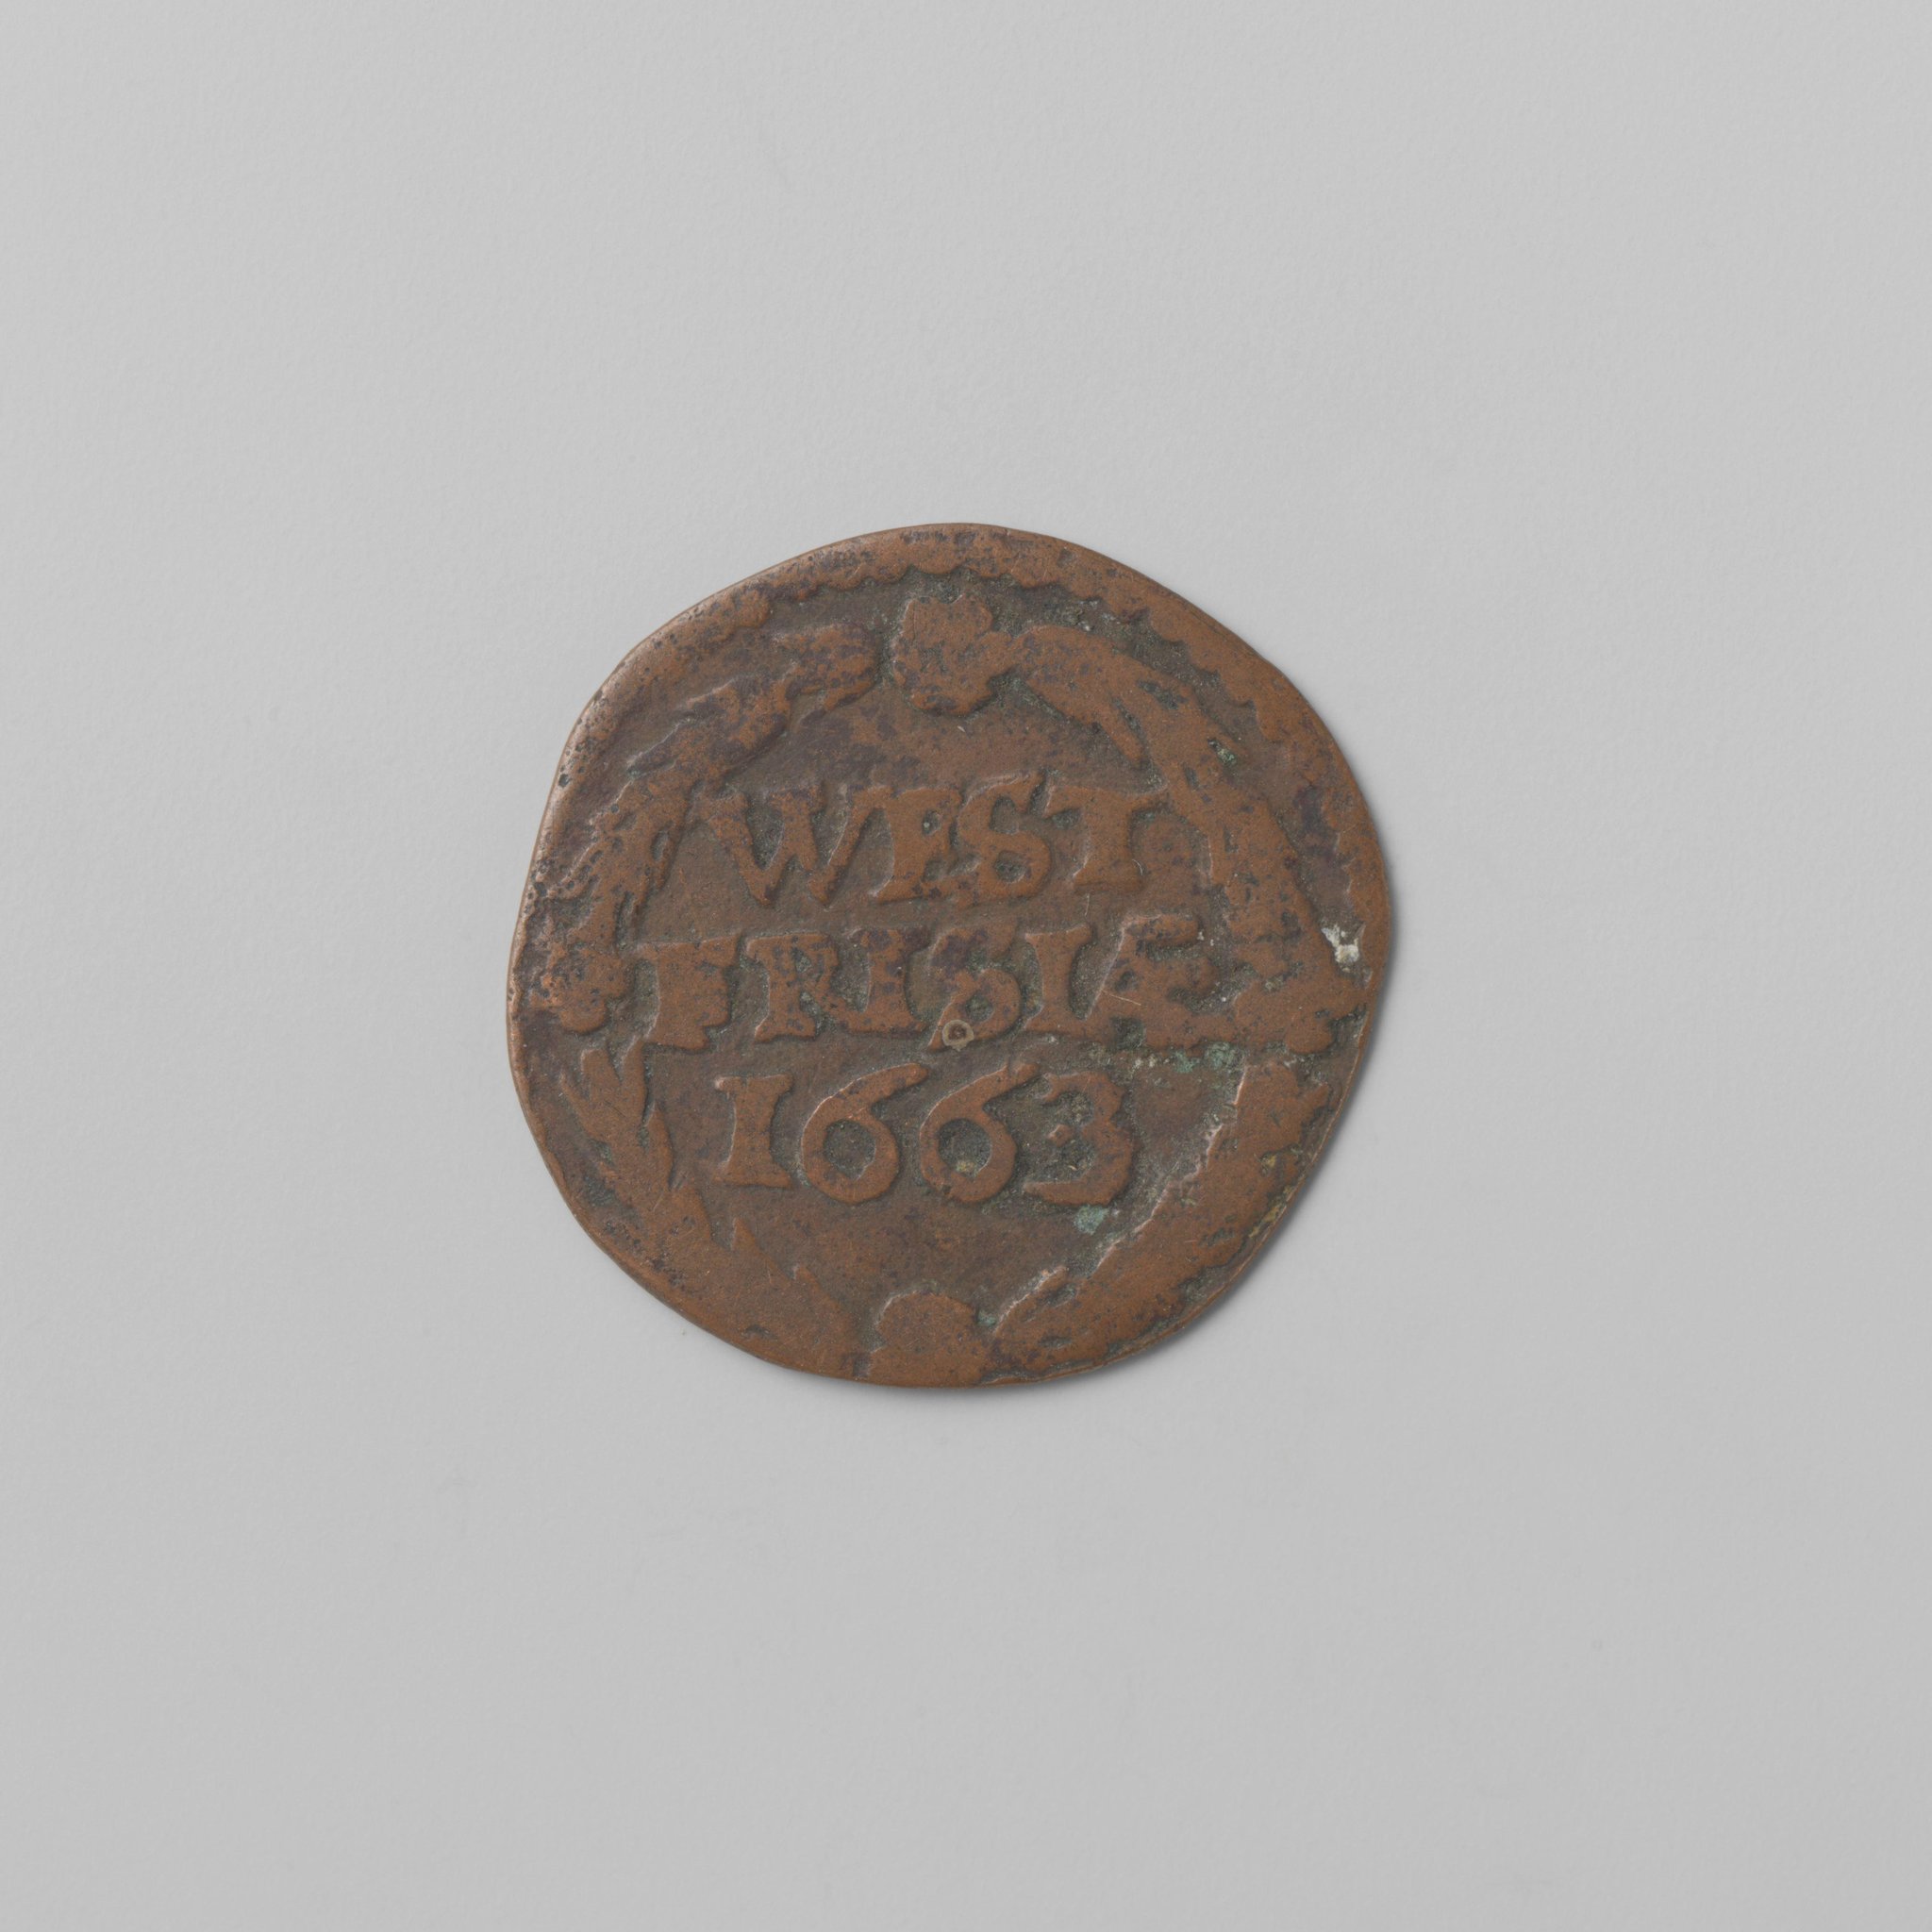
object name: coin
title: West-Friesland, duit, 1663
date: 1663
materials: copper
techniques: striking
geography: west frisia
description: Koperen munt. Voorzijde: gekroond en versierd wapenschild van West-Friesland. Keerzijde: binnen een bladerkrans opschrift in twee regels, opzij twee rozetten.